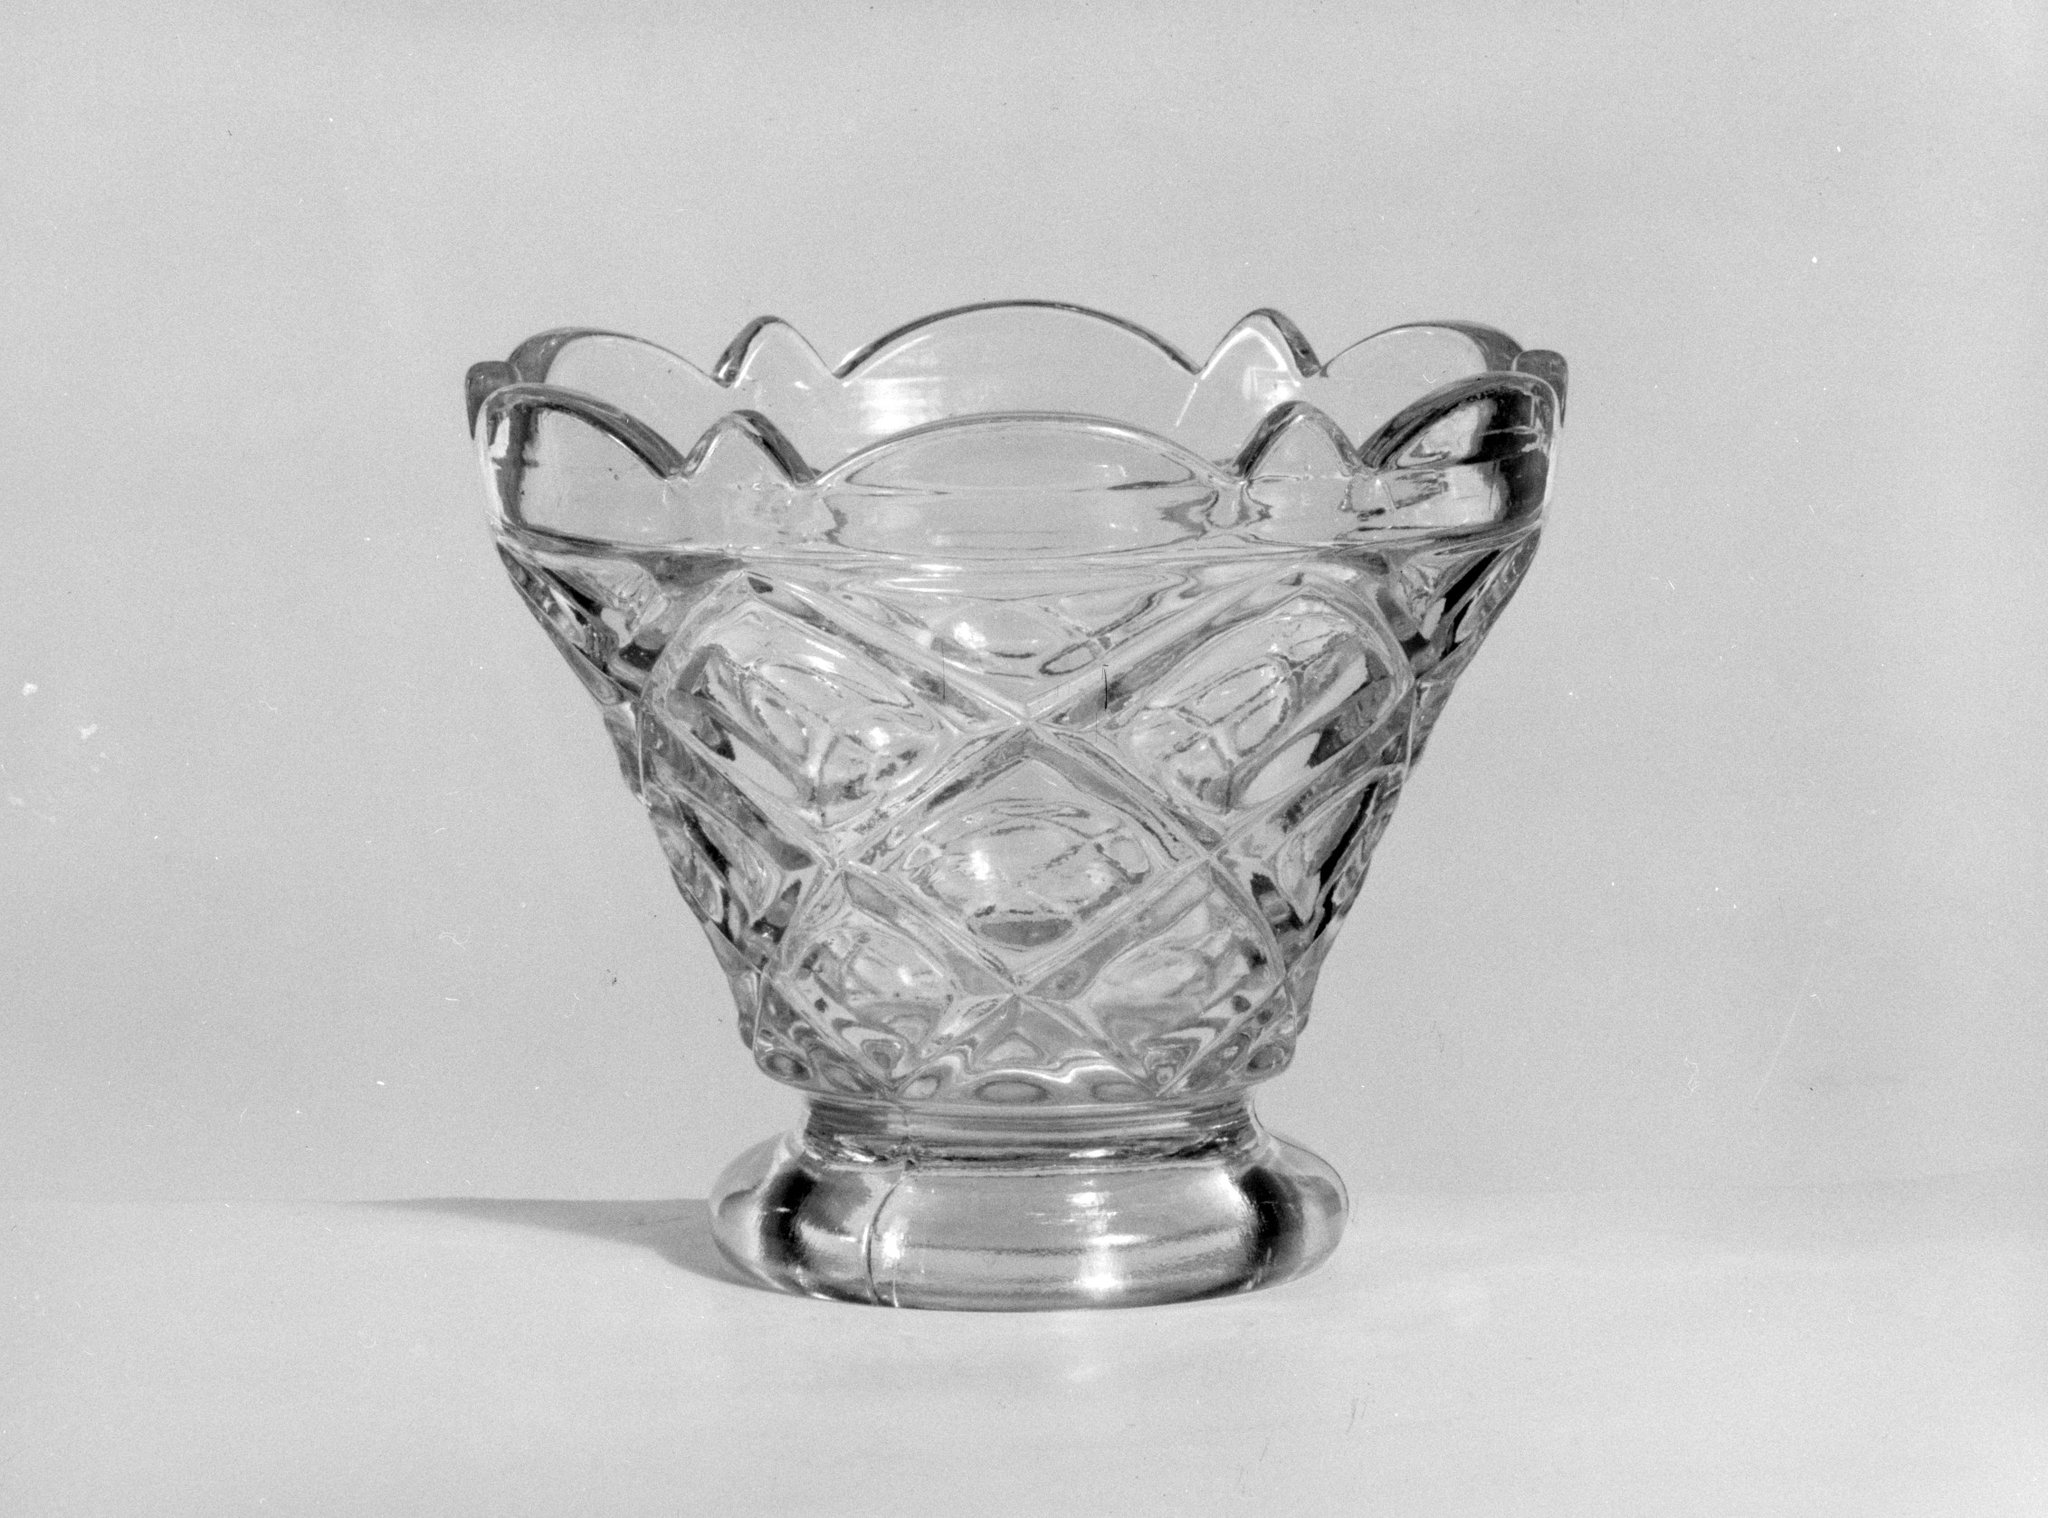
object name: bowl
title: Footed bowl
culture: american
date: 1850-1870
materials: diamond, glass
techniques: pressed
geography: united states